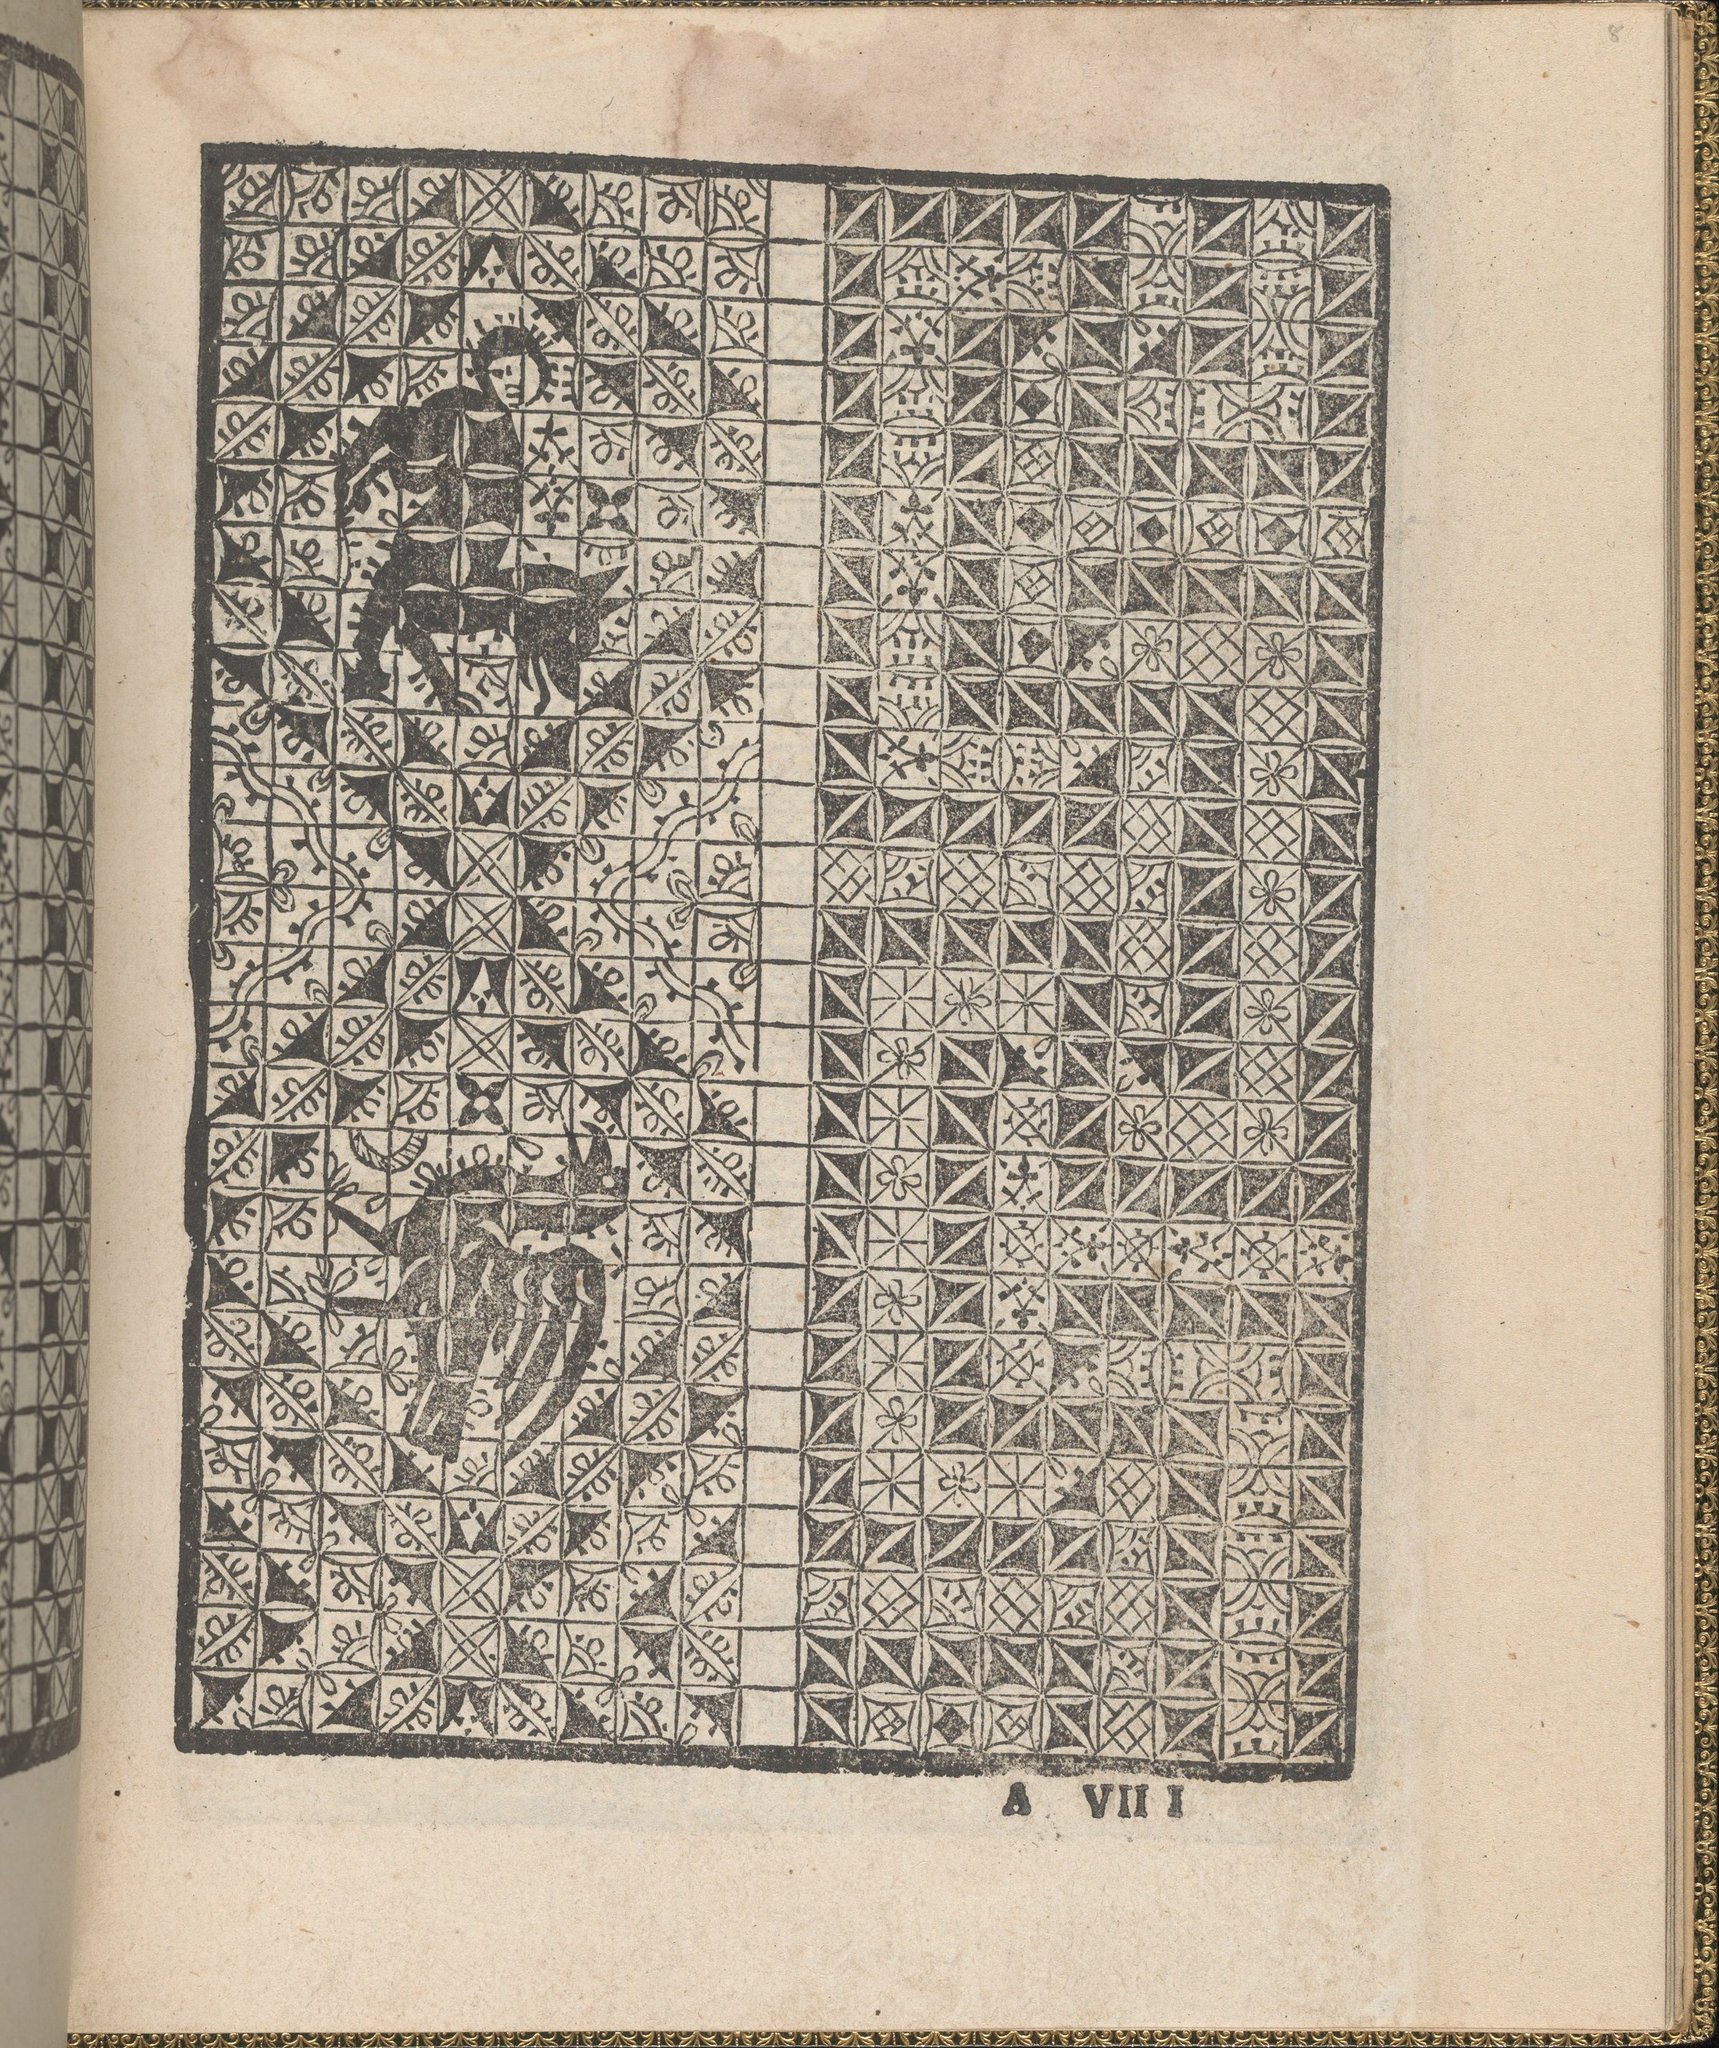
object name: book print ornament architecture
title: Giardineto novo di punti tagliati et gropposi per exercitio & ornamento delle donne (Venice 1554), page 5 (recto)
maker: matteo pagano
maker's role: publisher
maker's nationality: italian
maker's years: 1515-1588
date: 1554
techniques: woodcut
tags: animals,birds,ornament